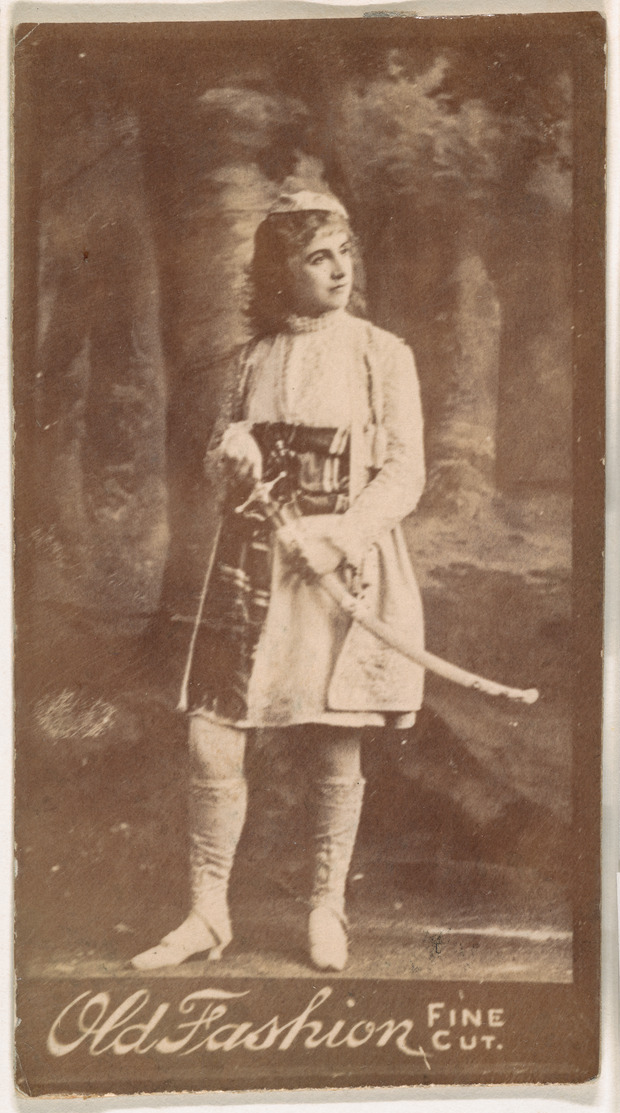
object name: photograph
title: Actress wearing costume with sword, from the Actresses series (N664) promoting Old Fashion Fine Cut Tobacco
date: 1888-1890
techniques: albumen silver print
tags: portraits,women,actresses